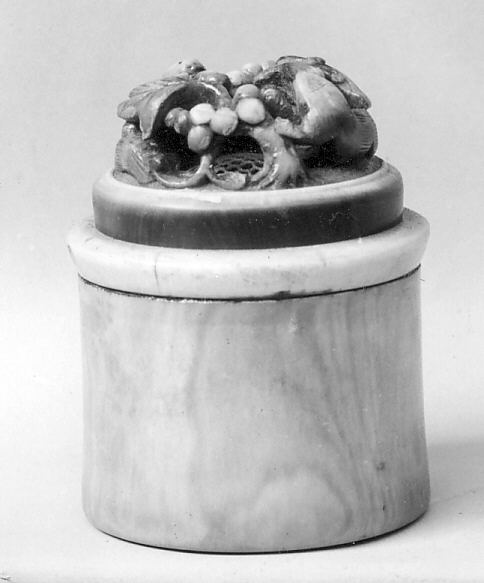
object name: cricket cage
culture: chinese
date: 1701-1900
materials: ivory